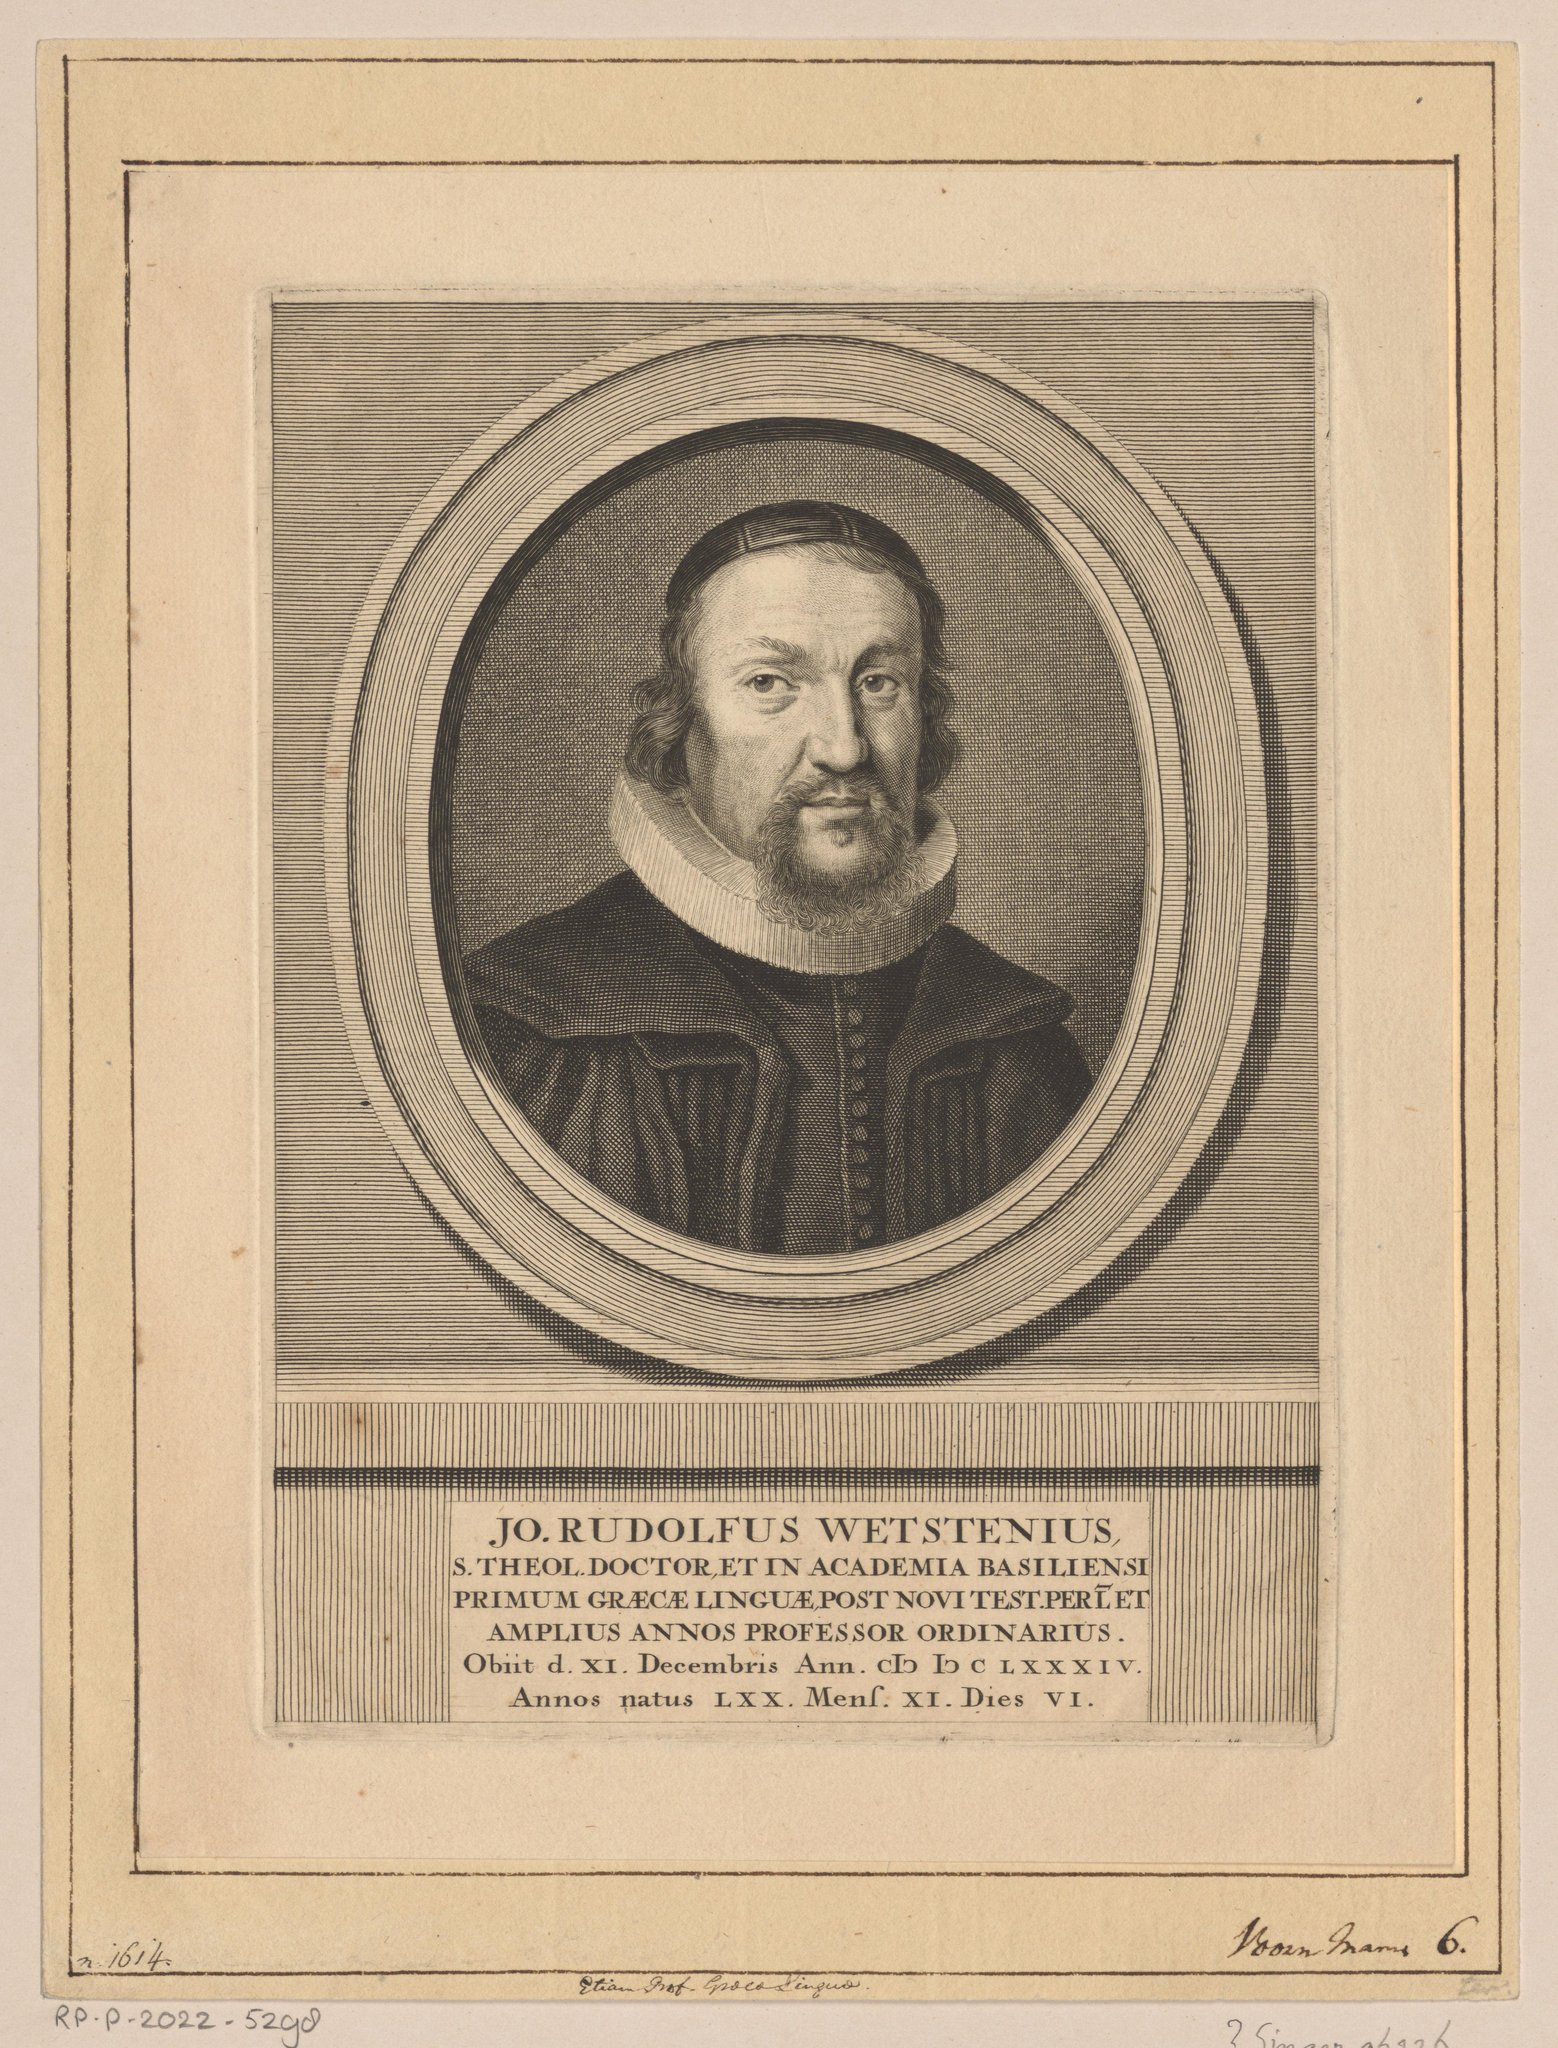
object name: print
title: Portret van Johann Rudolf Wettstein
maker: Anonymous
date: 1700-1799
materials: paper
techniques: engraving, etching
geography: switzerland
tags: theologian, historical persons, professor